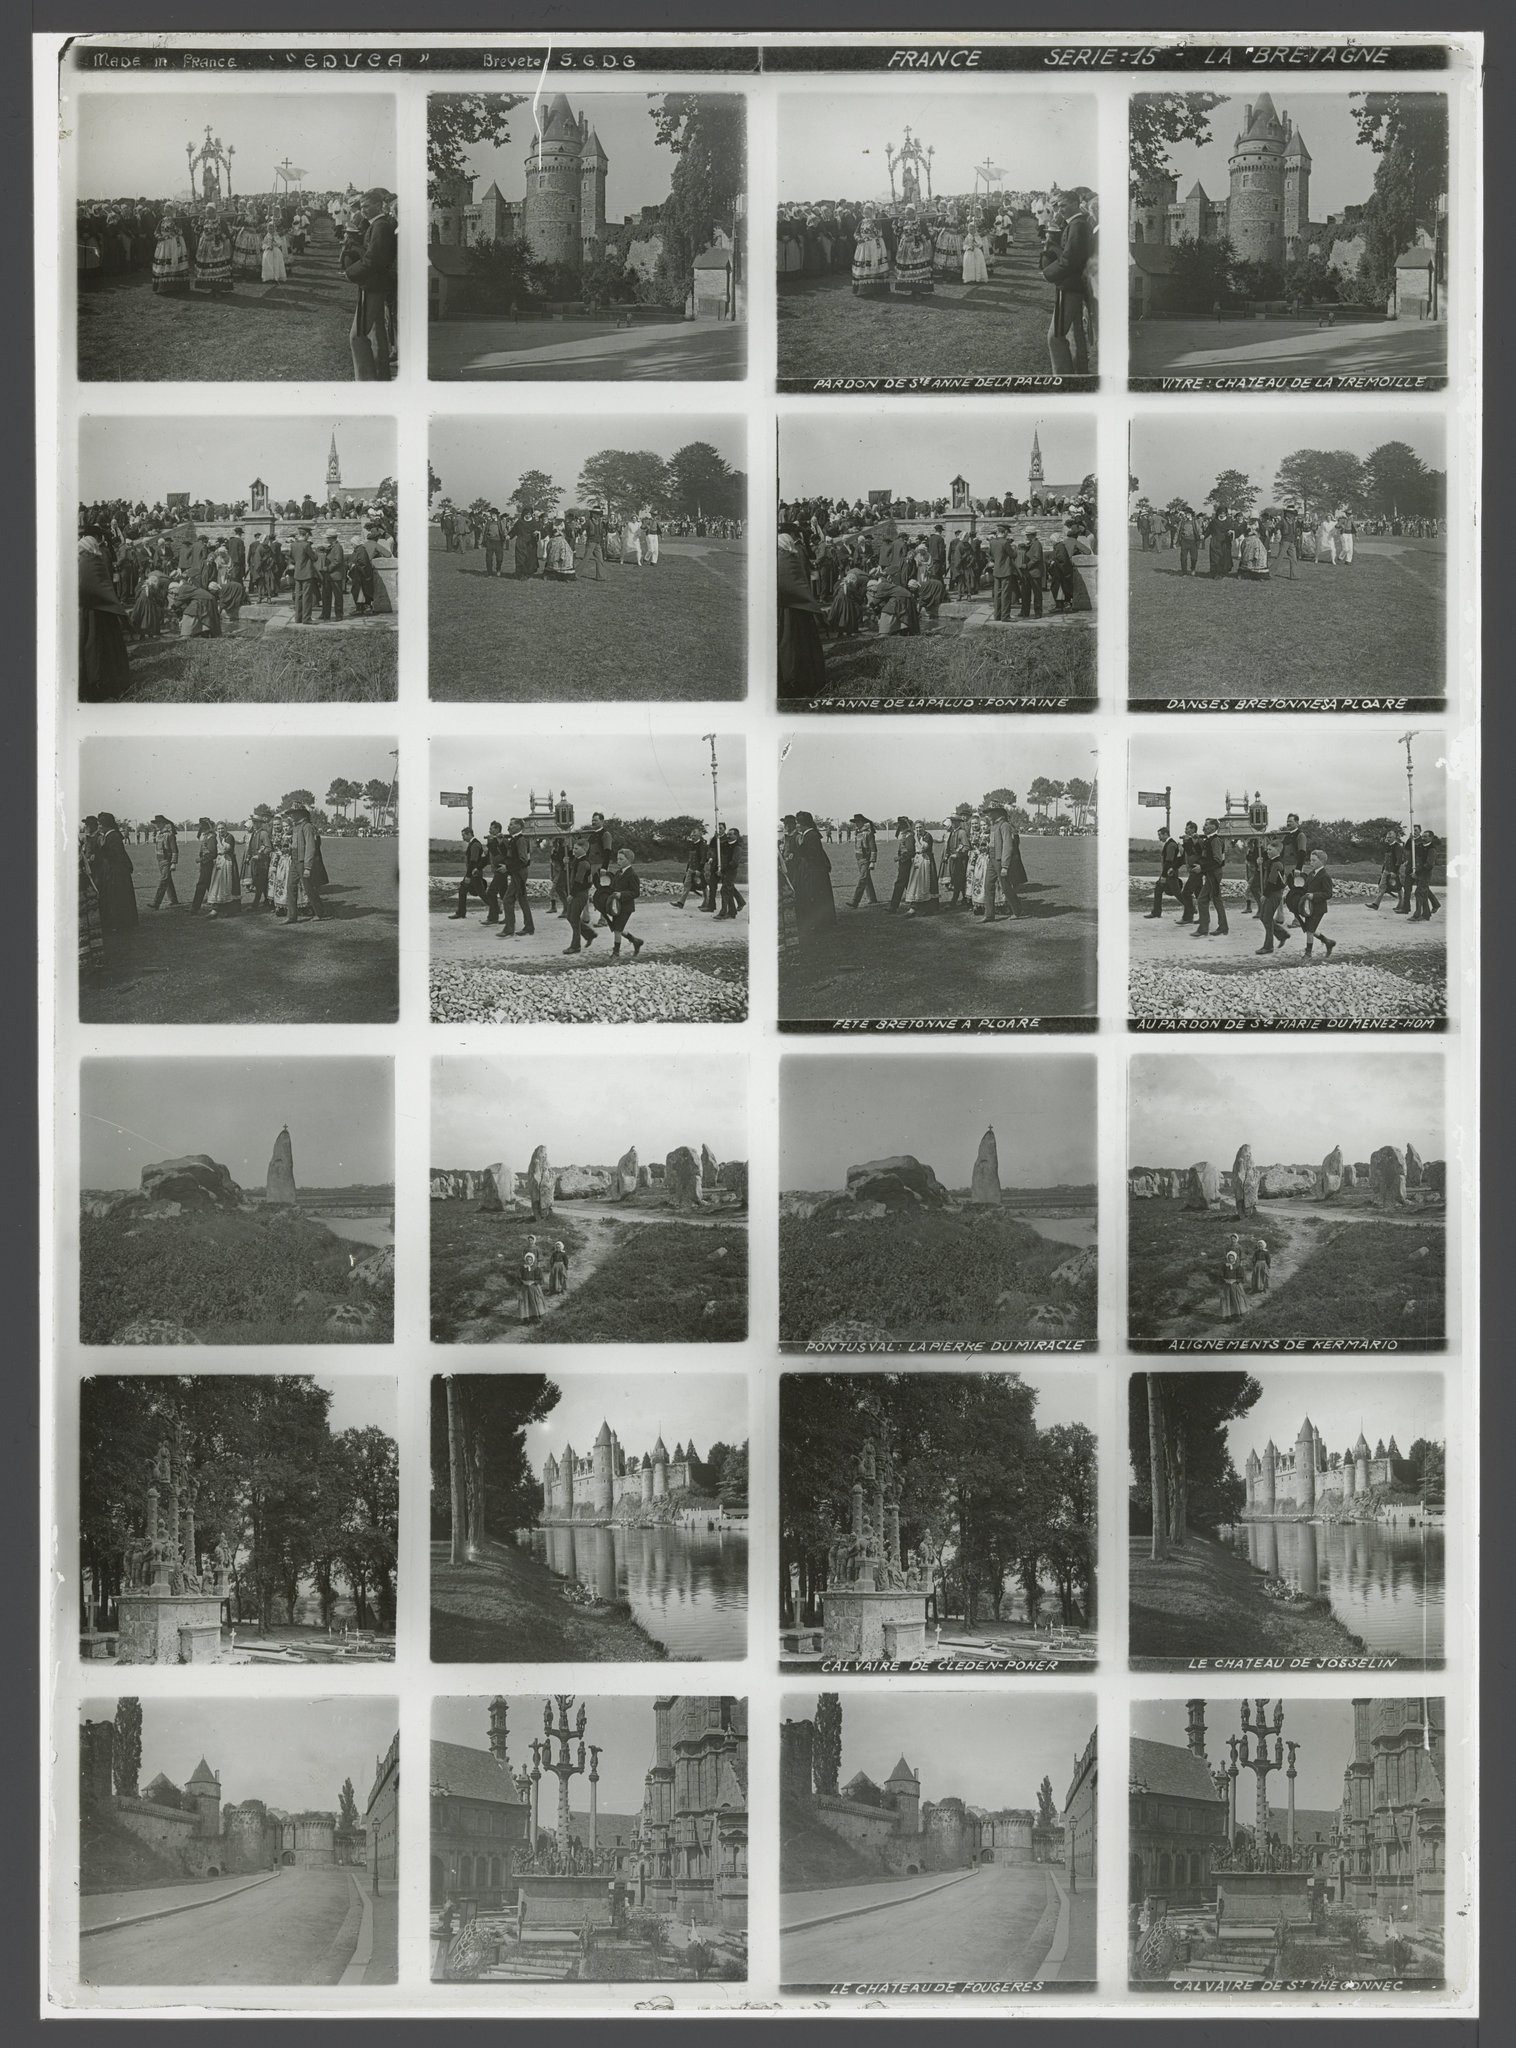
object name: stereoscopic photograph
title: Twaalf stereoscopische opnamen van plaatsen en feestelijkheden in Bretagne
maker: Anonymous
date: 1920-1925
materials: glass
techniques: gelatin silver transparency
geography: brittany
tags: castle, public festivities, group dancing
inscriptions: inscription: ‘Made in France (...) Brevete S.G.D.G. (...)’